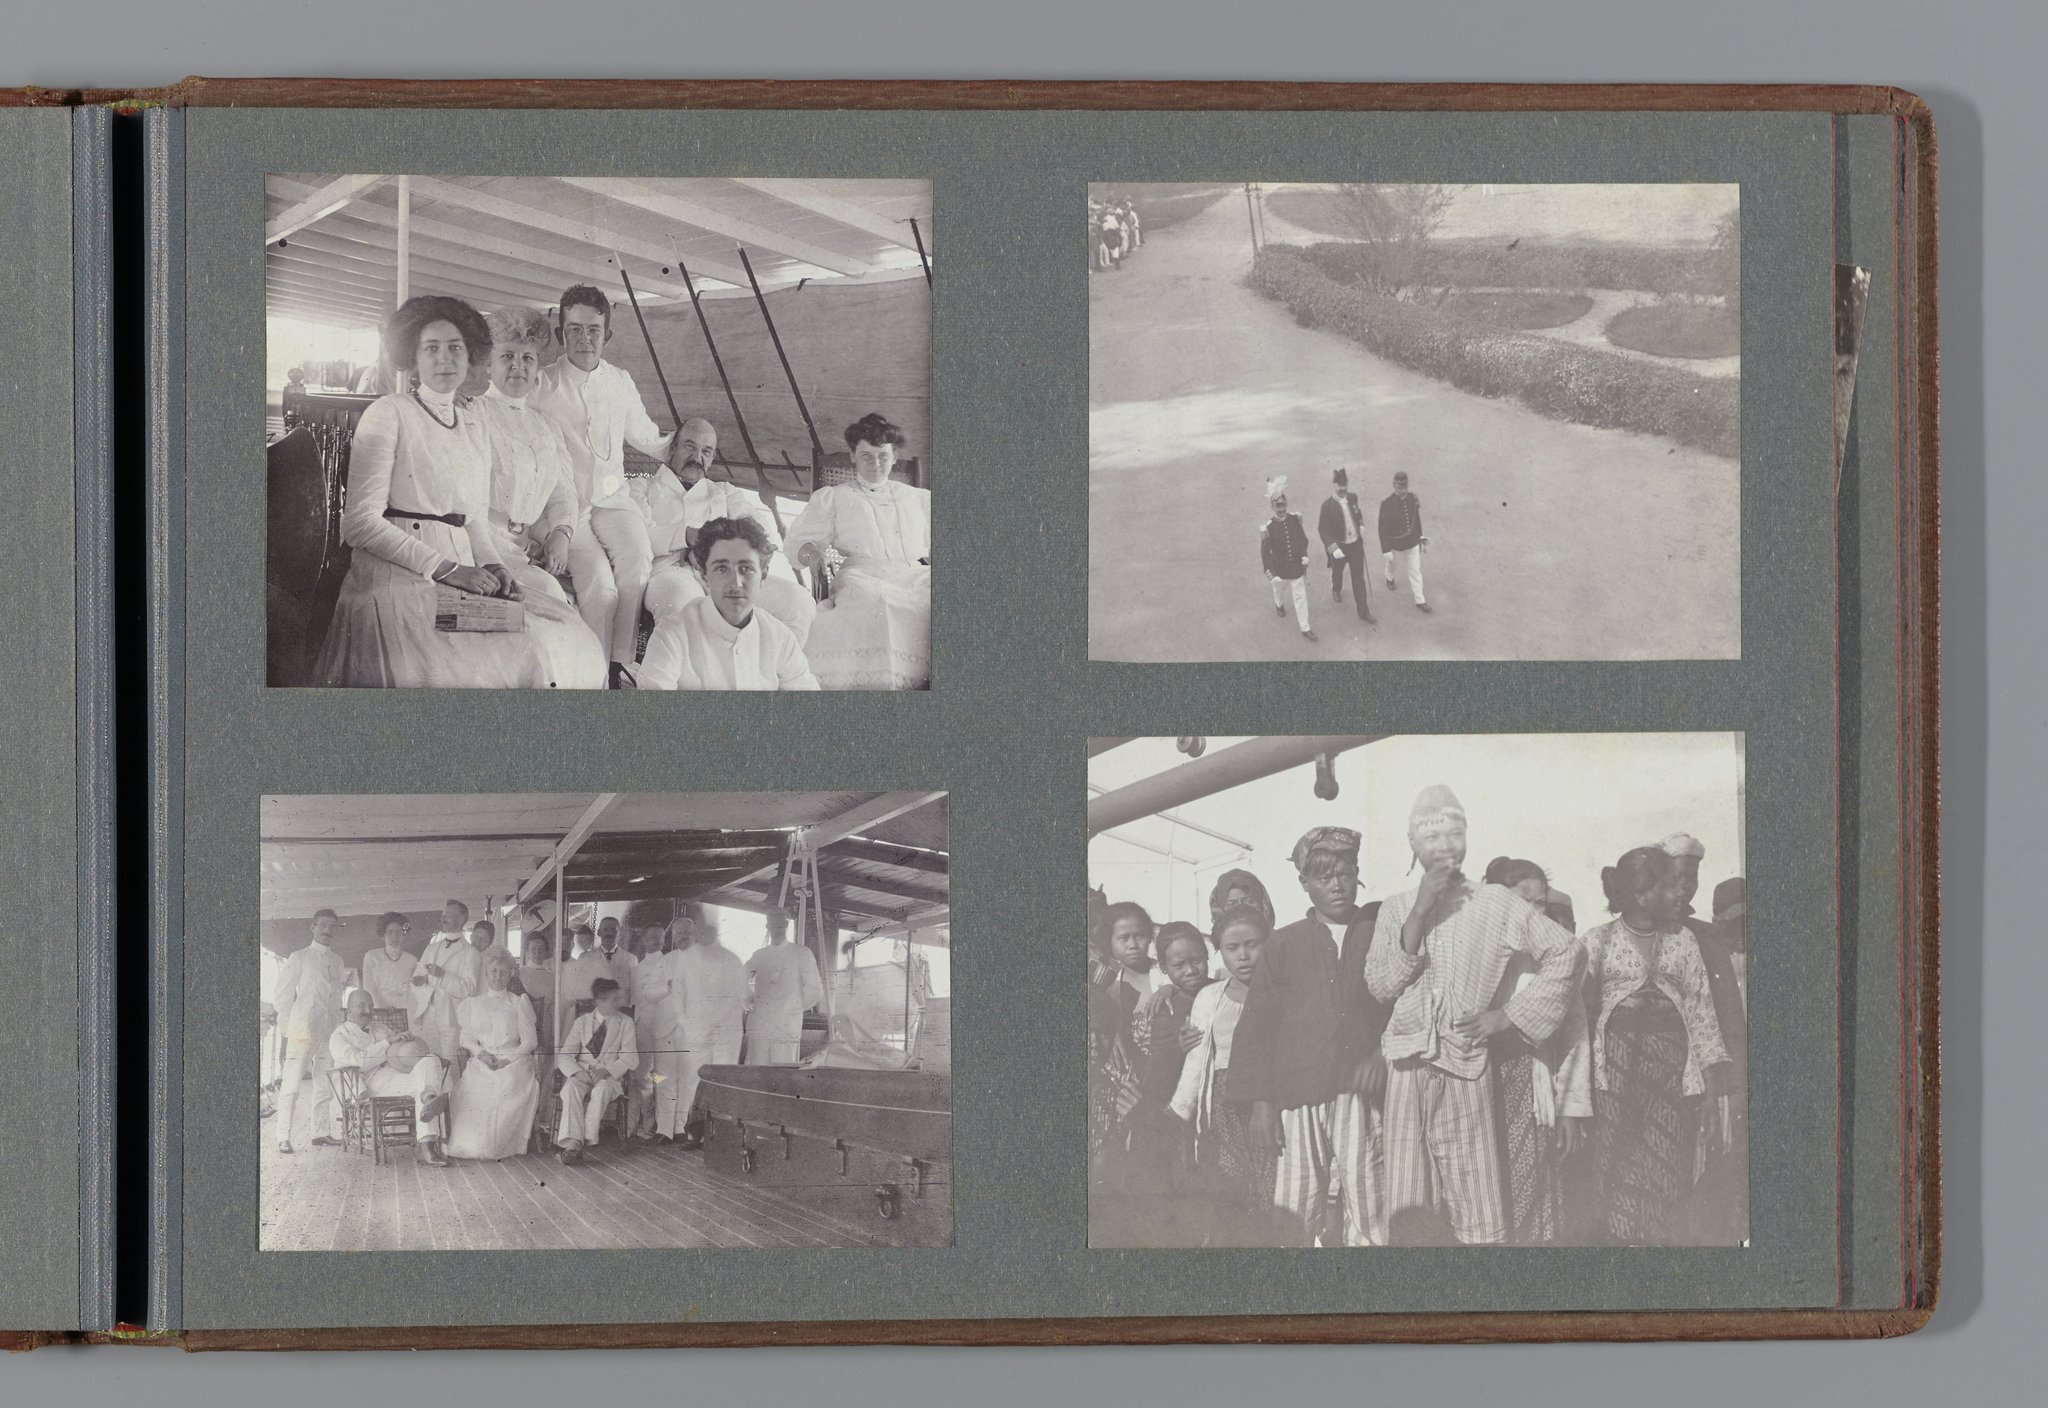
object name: photograph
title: Groep Surinamers op het dek van een schip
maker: Anonymous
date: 1905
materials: cardboard, paper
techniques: photography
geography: paramaribo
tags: suriname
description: Groep Surinamers op het dek van een schip. Onderdeel van fotoalbum 'Suriname'.